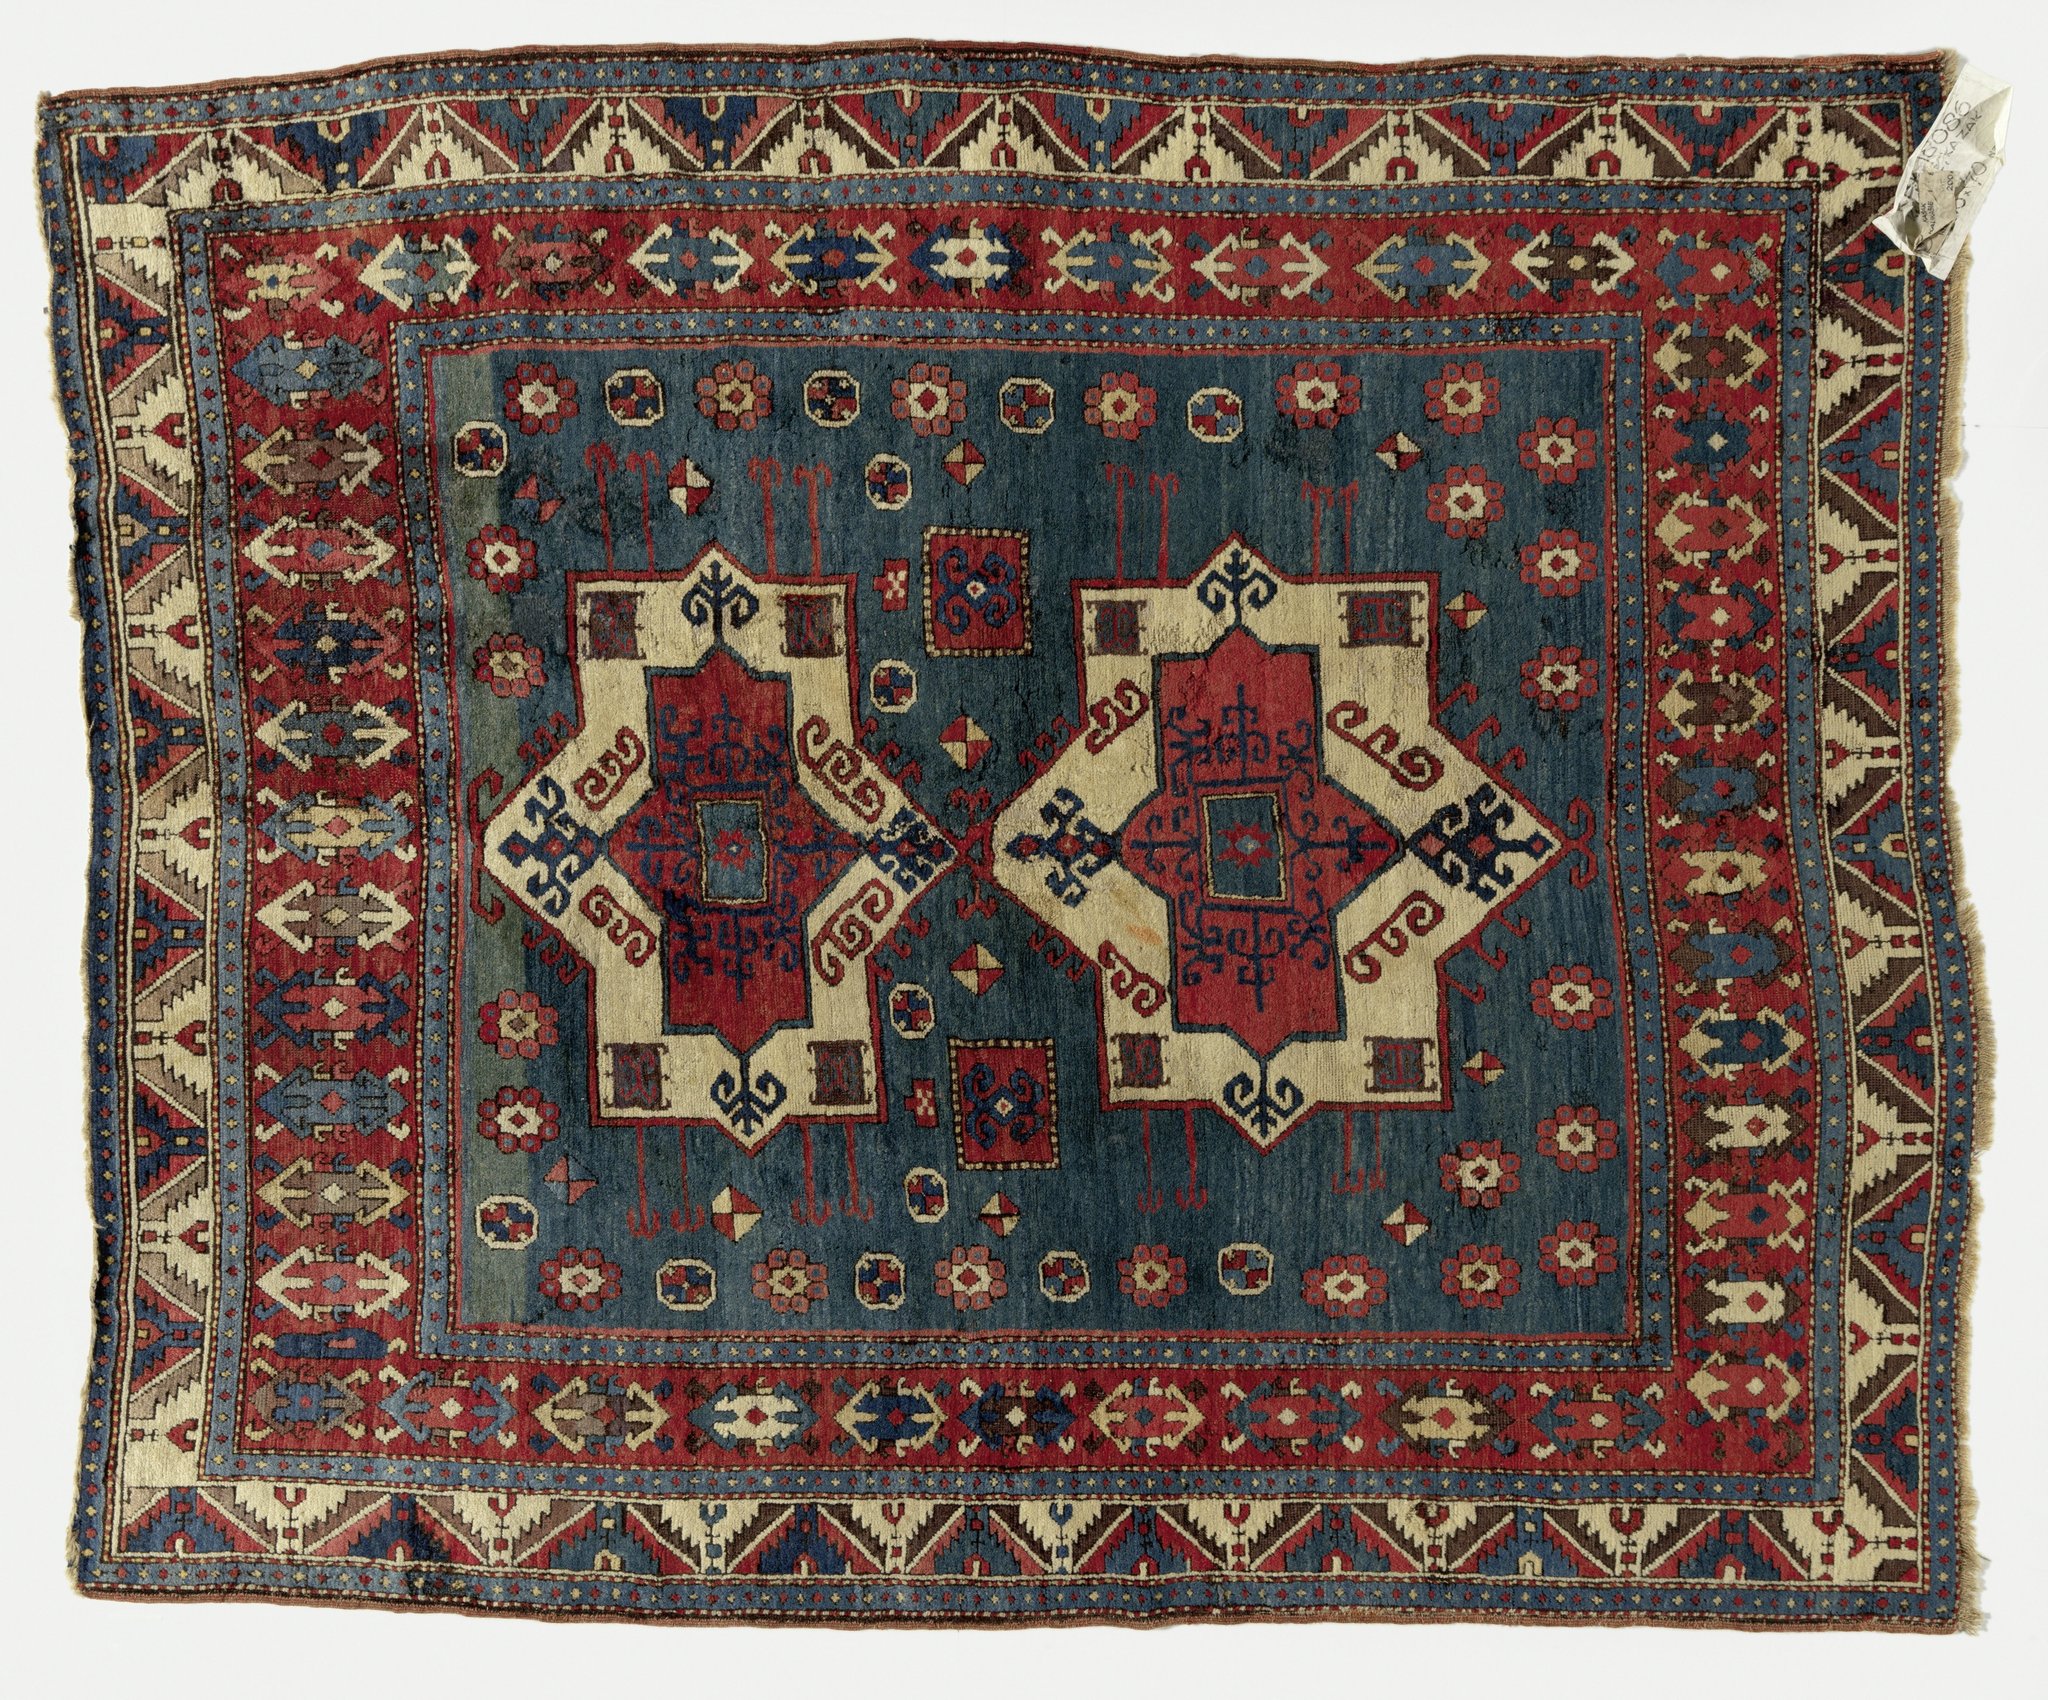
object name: oriental rug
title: Oosters tapijt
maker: Anonymous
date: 1800-1850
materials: wool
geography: kazakhstan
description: Oosters tapijt, medaillonkleed, met op het middenveld twee achtpuntige stervormen, bestaande uit concentrische medaillons. Rondom strooimotieven. De buitenste rand is versierd met een 'wijnglas-en-blad'-patroon.